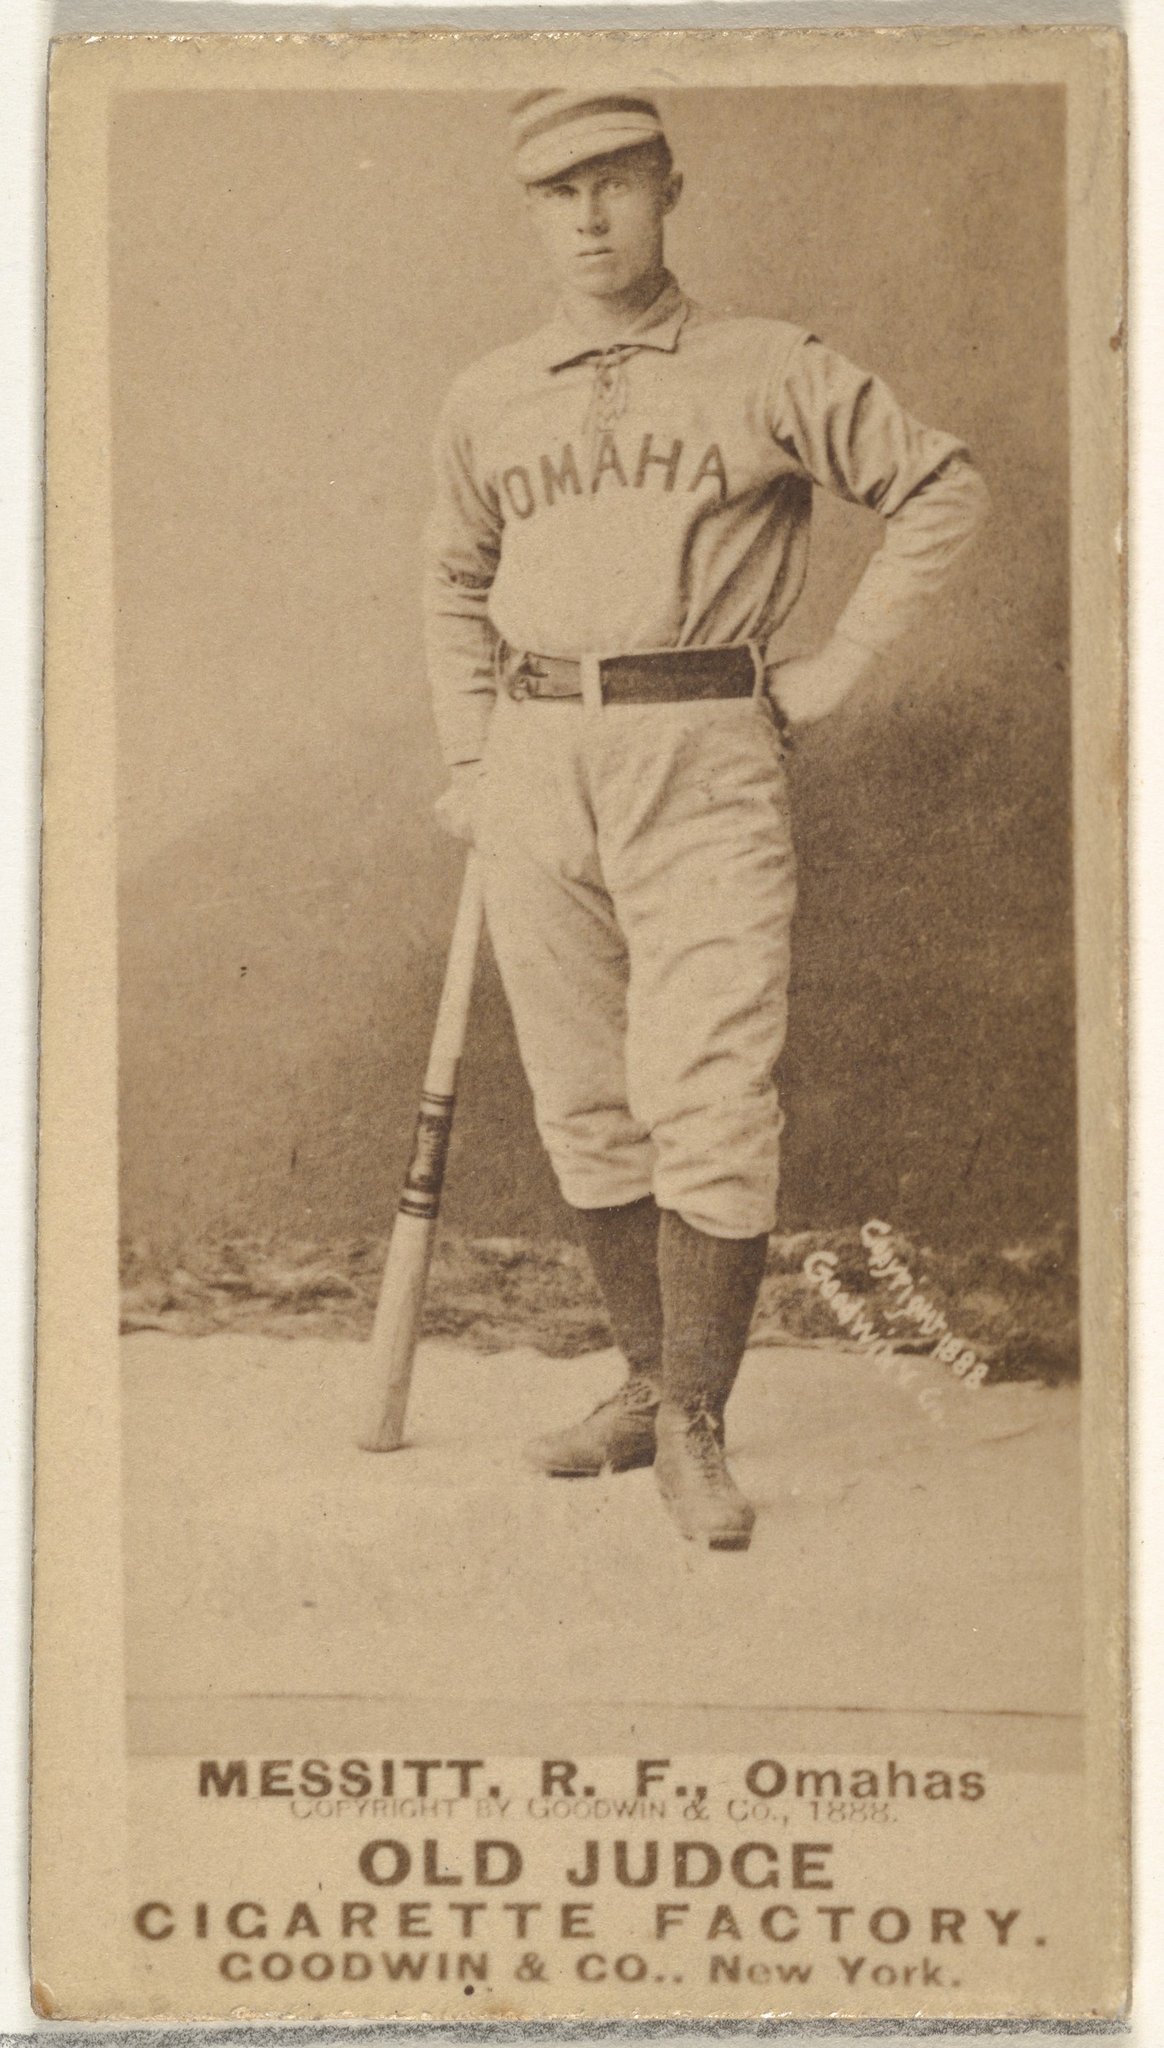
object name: baseball card, photograph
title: Messitt, Right Field, Omaha Omahogs/ Lambs, from the Old Judge series (N172) for Old Judge Cigarettes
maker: goodwin & company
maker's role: publisher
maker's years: 1850-1950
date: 1888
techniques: albumen silver print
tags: men,portraits,baseball,athletes